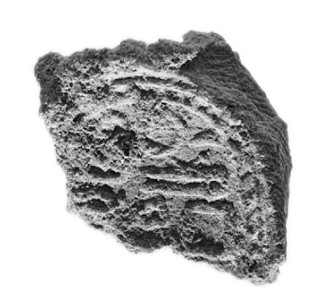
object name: sealing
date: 1981-1640 BCE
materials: mud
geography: egypt